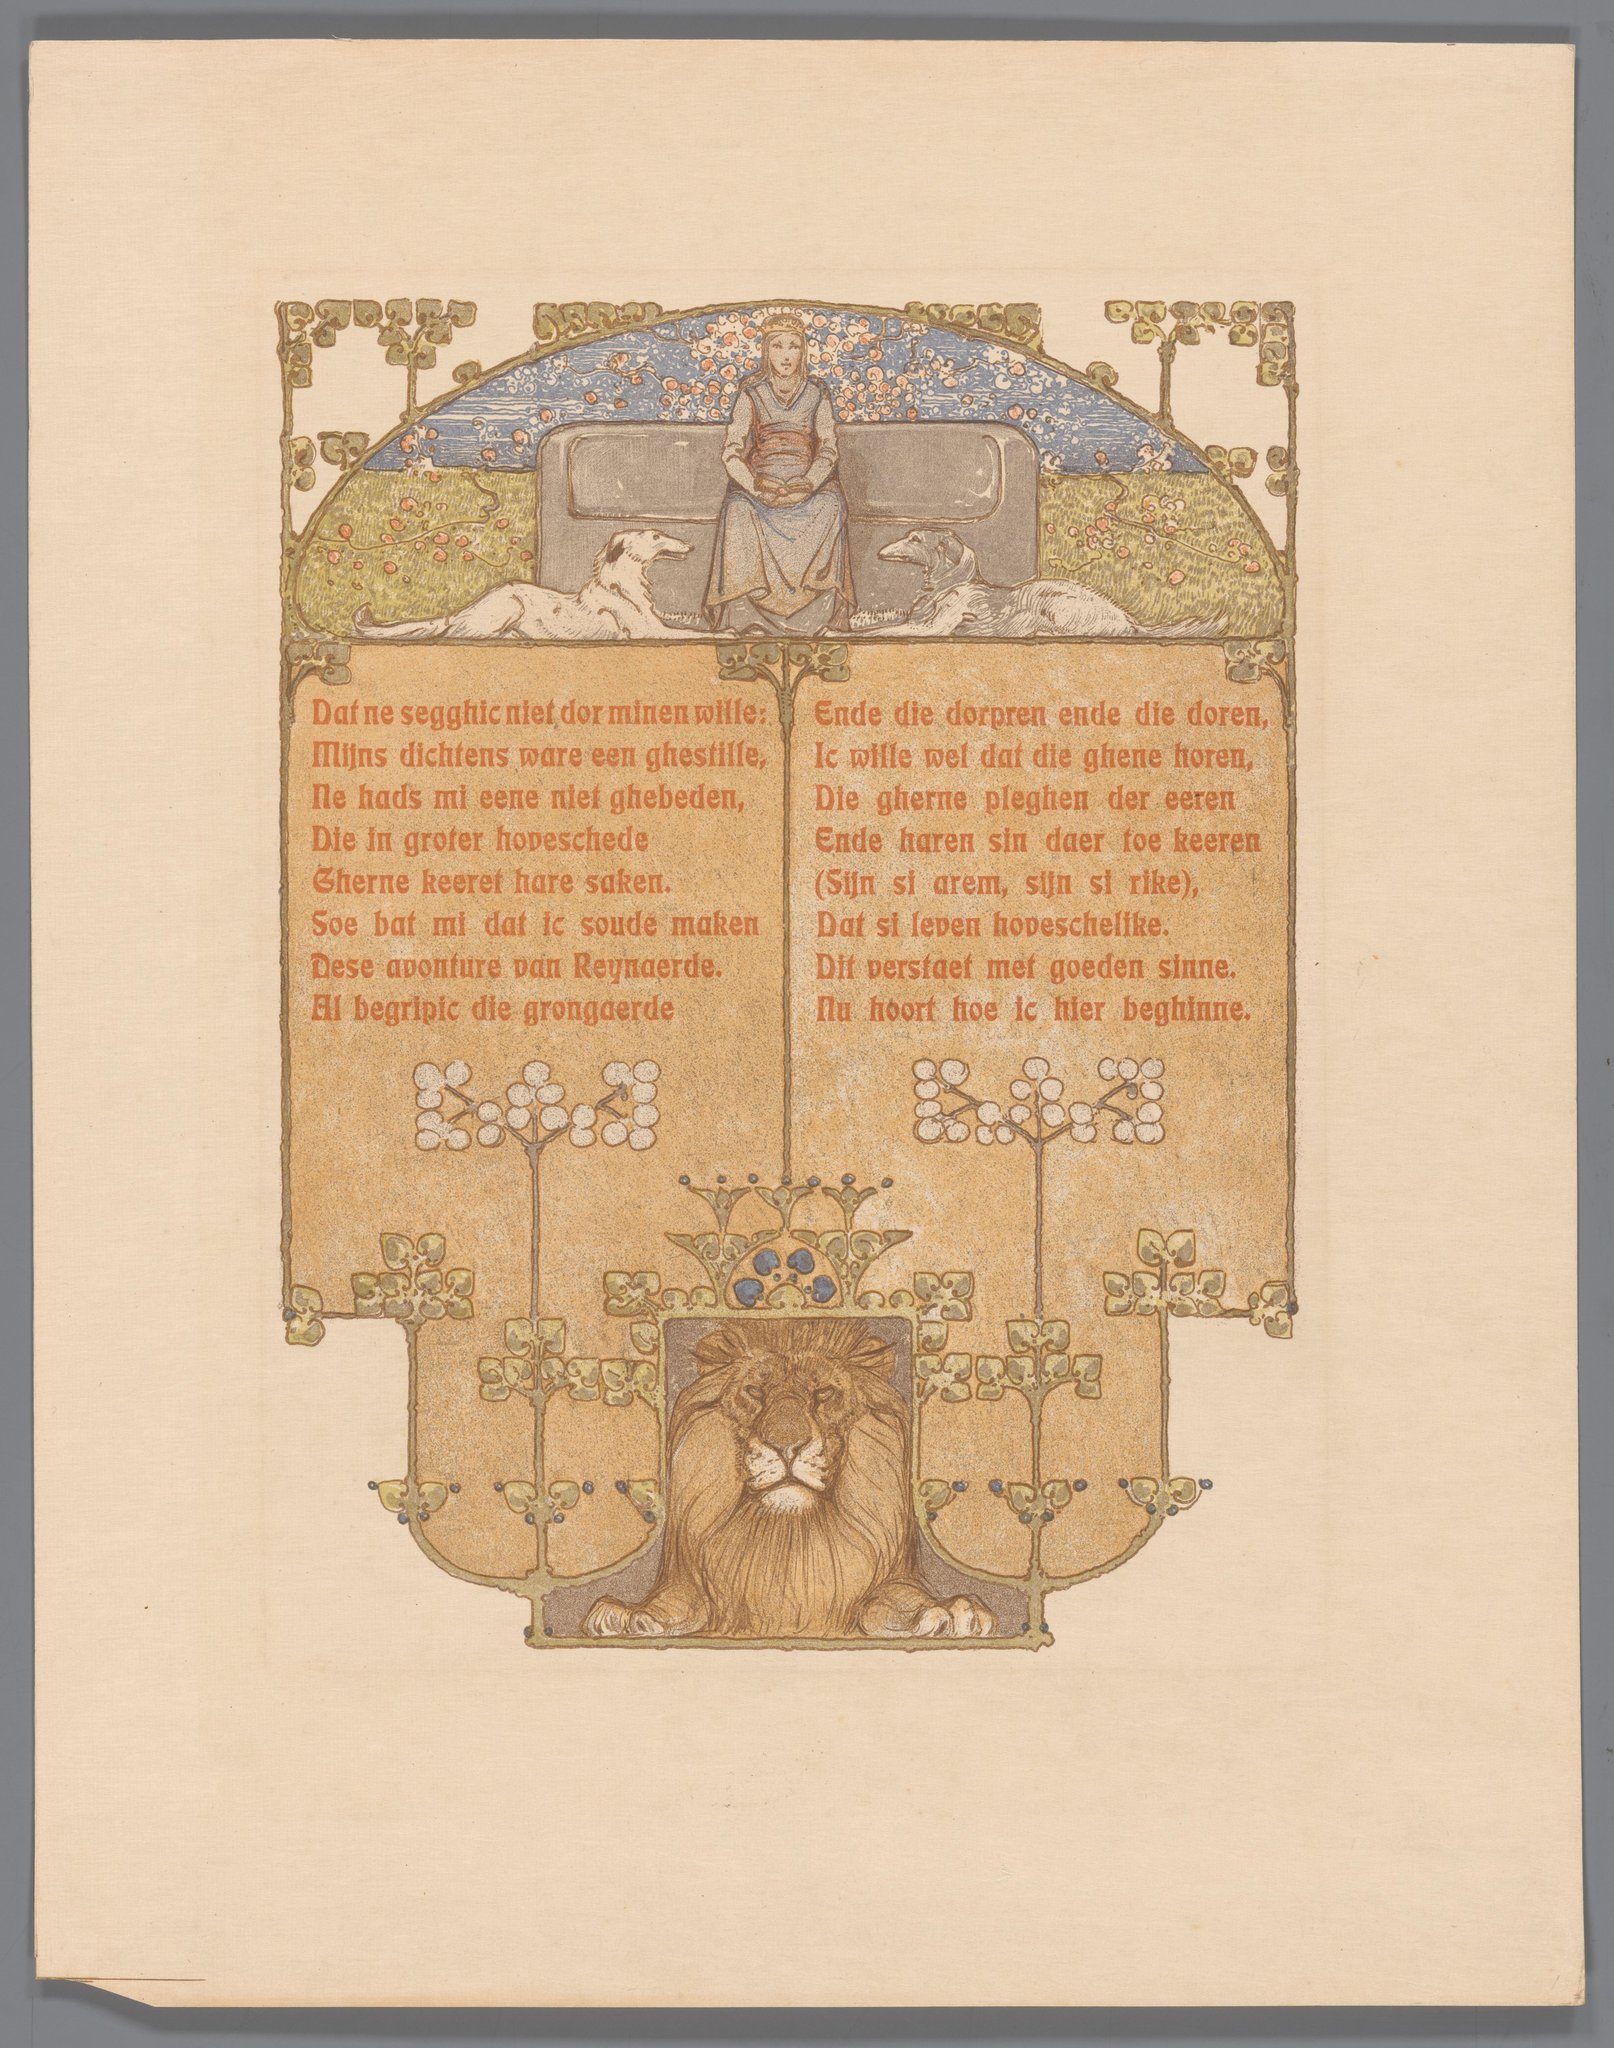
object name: print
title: Zittende vrouw, twee honden en een leeuw (Nobel)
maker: bernard willem wierink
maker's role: draughtsman, print maker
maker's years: 1856-1939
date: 1910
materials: paper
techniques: lithograph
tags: fable of reynard the fox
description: Prent gebruikt in: Streuvels, Stijn (Frank Lateur). Reinaert de Vos naar verschillende uitgaven van het middeleeuwsche epos. Amsterdam: L.J. Veen, 1910.